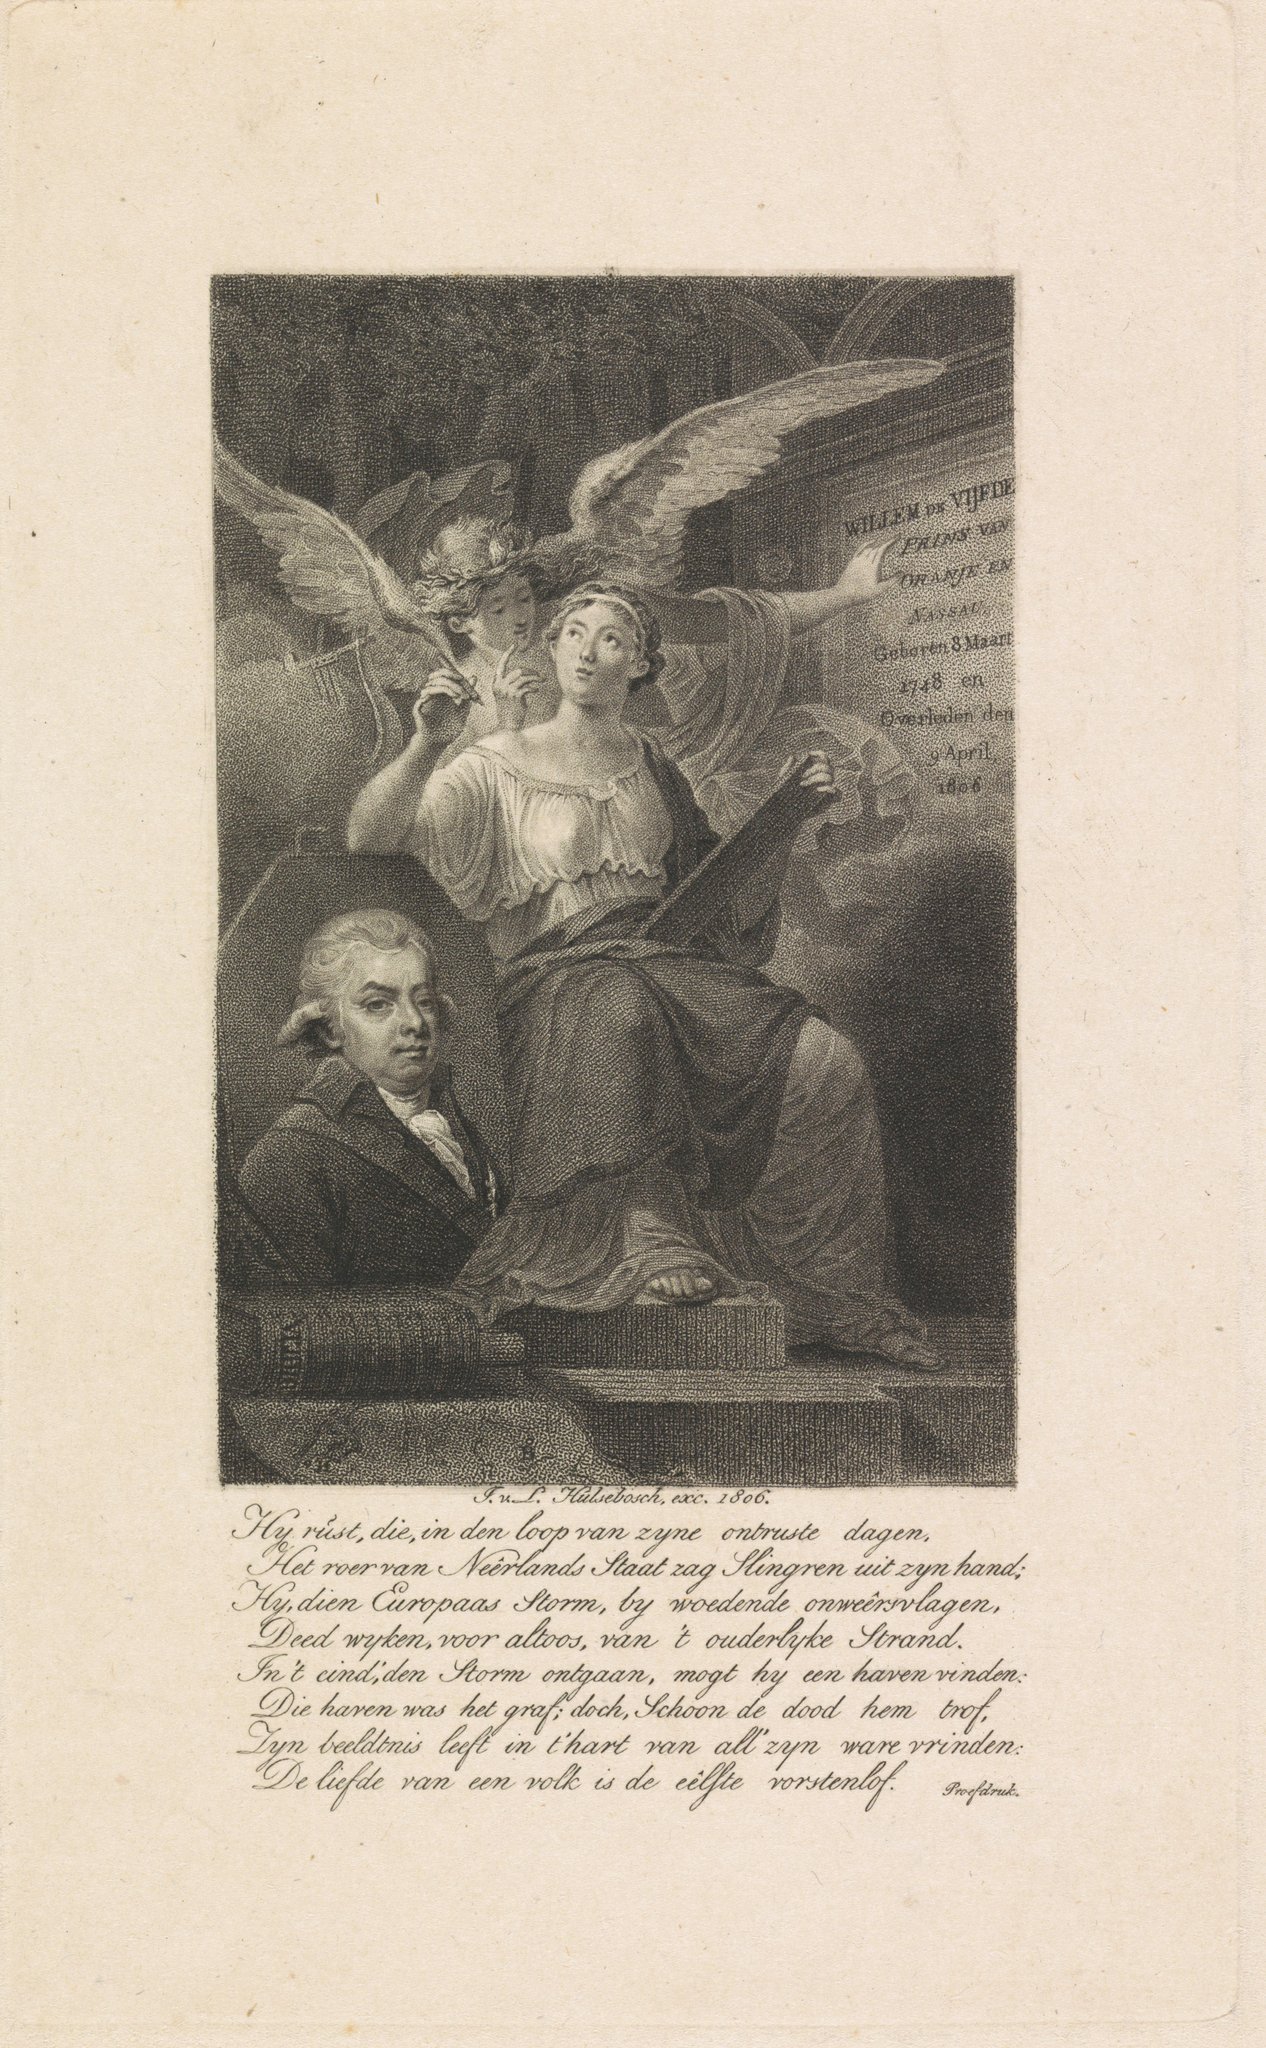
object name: print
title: Allegorisch grafmonument voor prins Willem V, 1806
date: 1800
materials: paper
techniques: stippled etching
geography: amsterdam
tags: the hague, william v (prince of orange), 'historia'; 'historia' (ripa), grave-building, monumental tomb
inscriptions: collector's mark: Lugt 2228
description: Allegorisch grafmonument voor prins Willem V, overleden op 9 april 1806. Bij de tombe van de prins schrijft de Historia geschiedenis. Een genius met een lier in de hand inspireert haar. Linksonder een portret van de prins in driekwart naar rechts, hierbij een Bijbel en een kaart. Bij de prent behoort een blad met een verklaring.